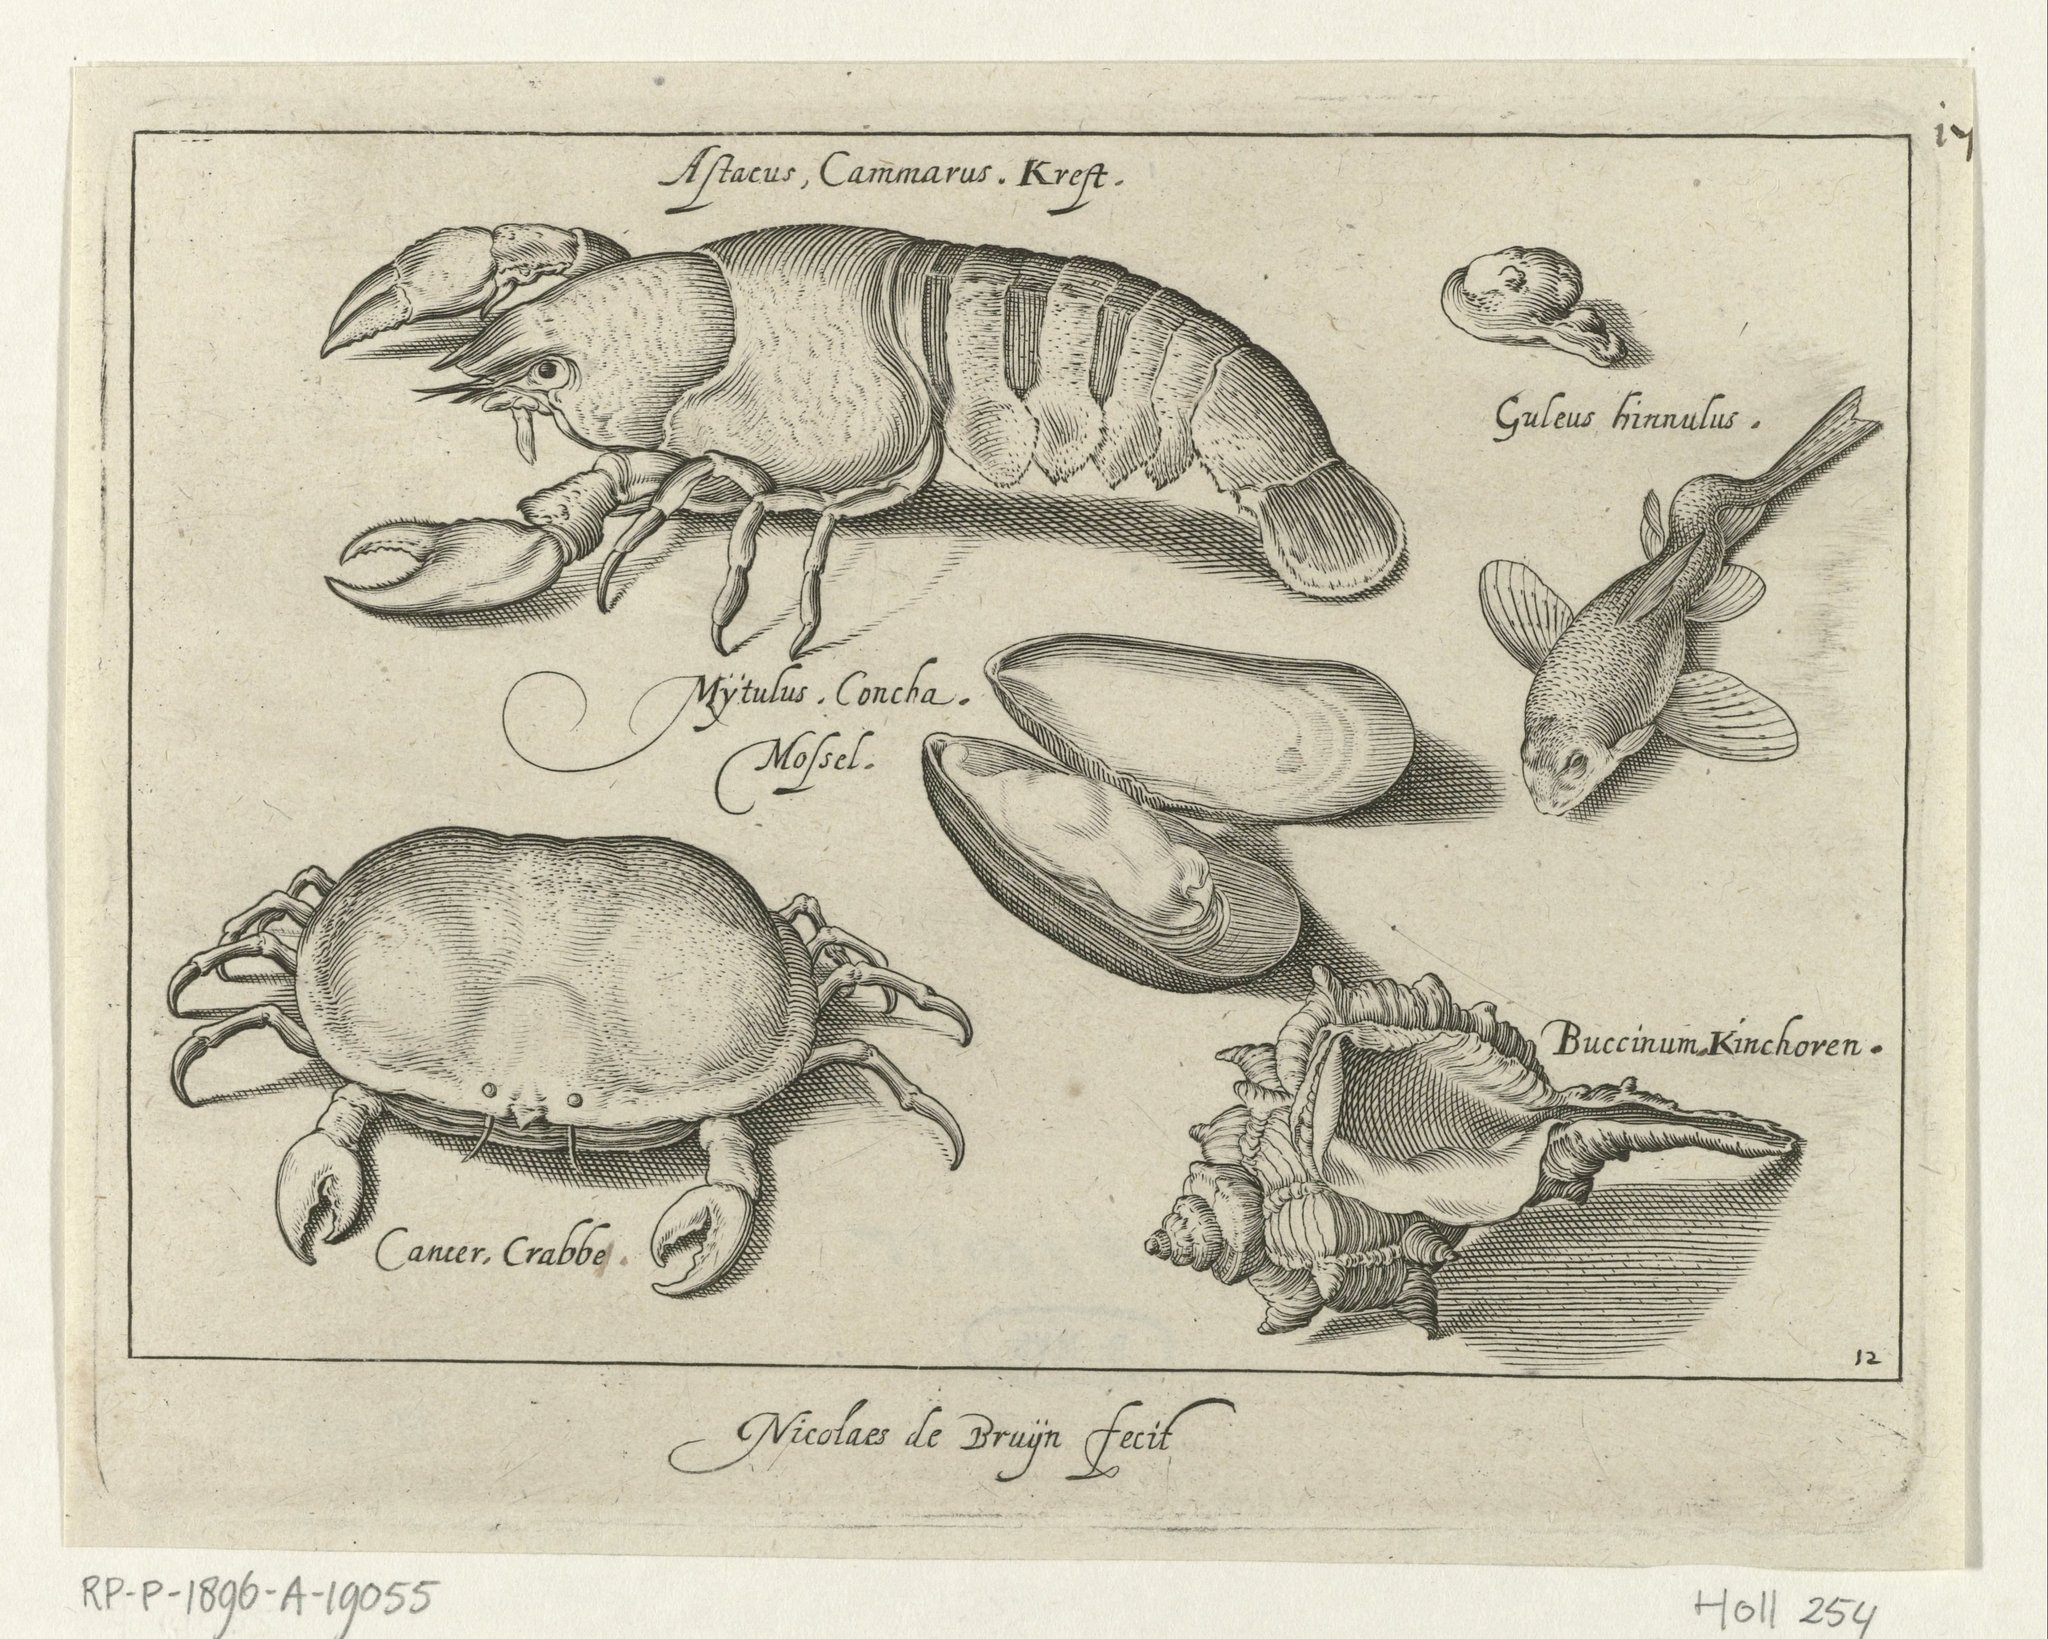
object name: print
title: Libelivs varia Genera piscium complectens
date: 1581-1656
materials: paper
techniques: engraving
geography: netherlands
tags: molluscs, crustaceans: crab, molluscs: mussel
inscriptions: collector's mark: Lugt 2228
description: Prent uit serie Libelivs varia Genera piscium complectens van dertien prenten met zoetwatervissen, zeevissen, kikkers, schaaldieren en zeewezens (inclusief titelprent). Vermoedelijk ging een uitgave van Assuerus van Londerseel vooraf aan deze editie van Francoys van Beusekom, zie De Groot 1988, p. 38.